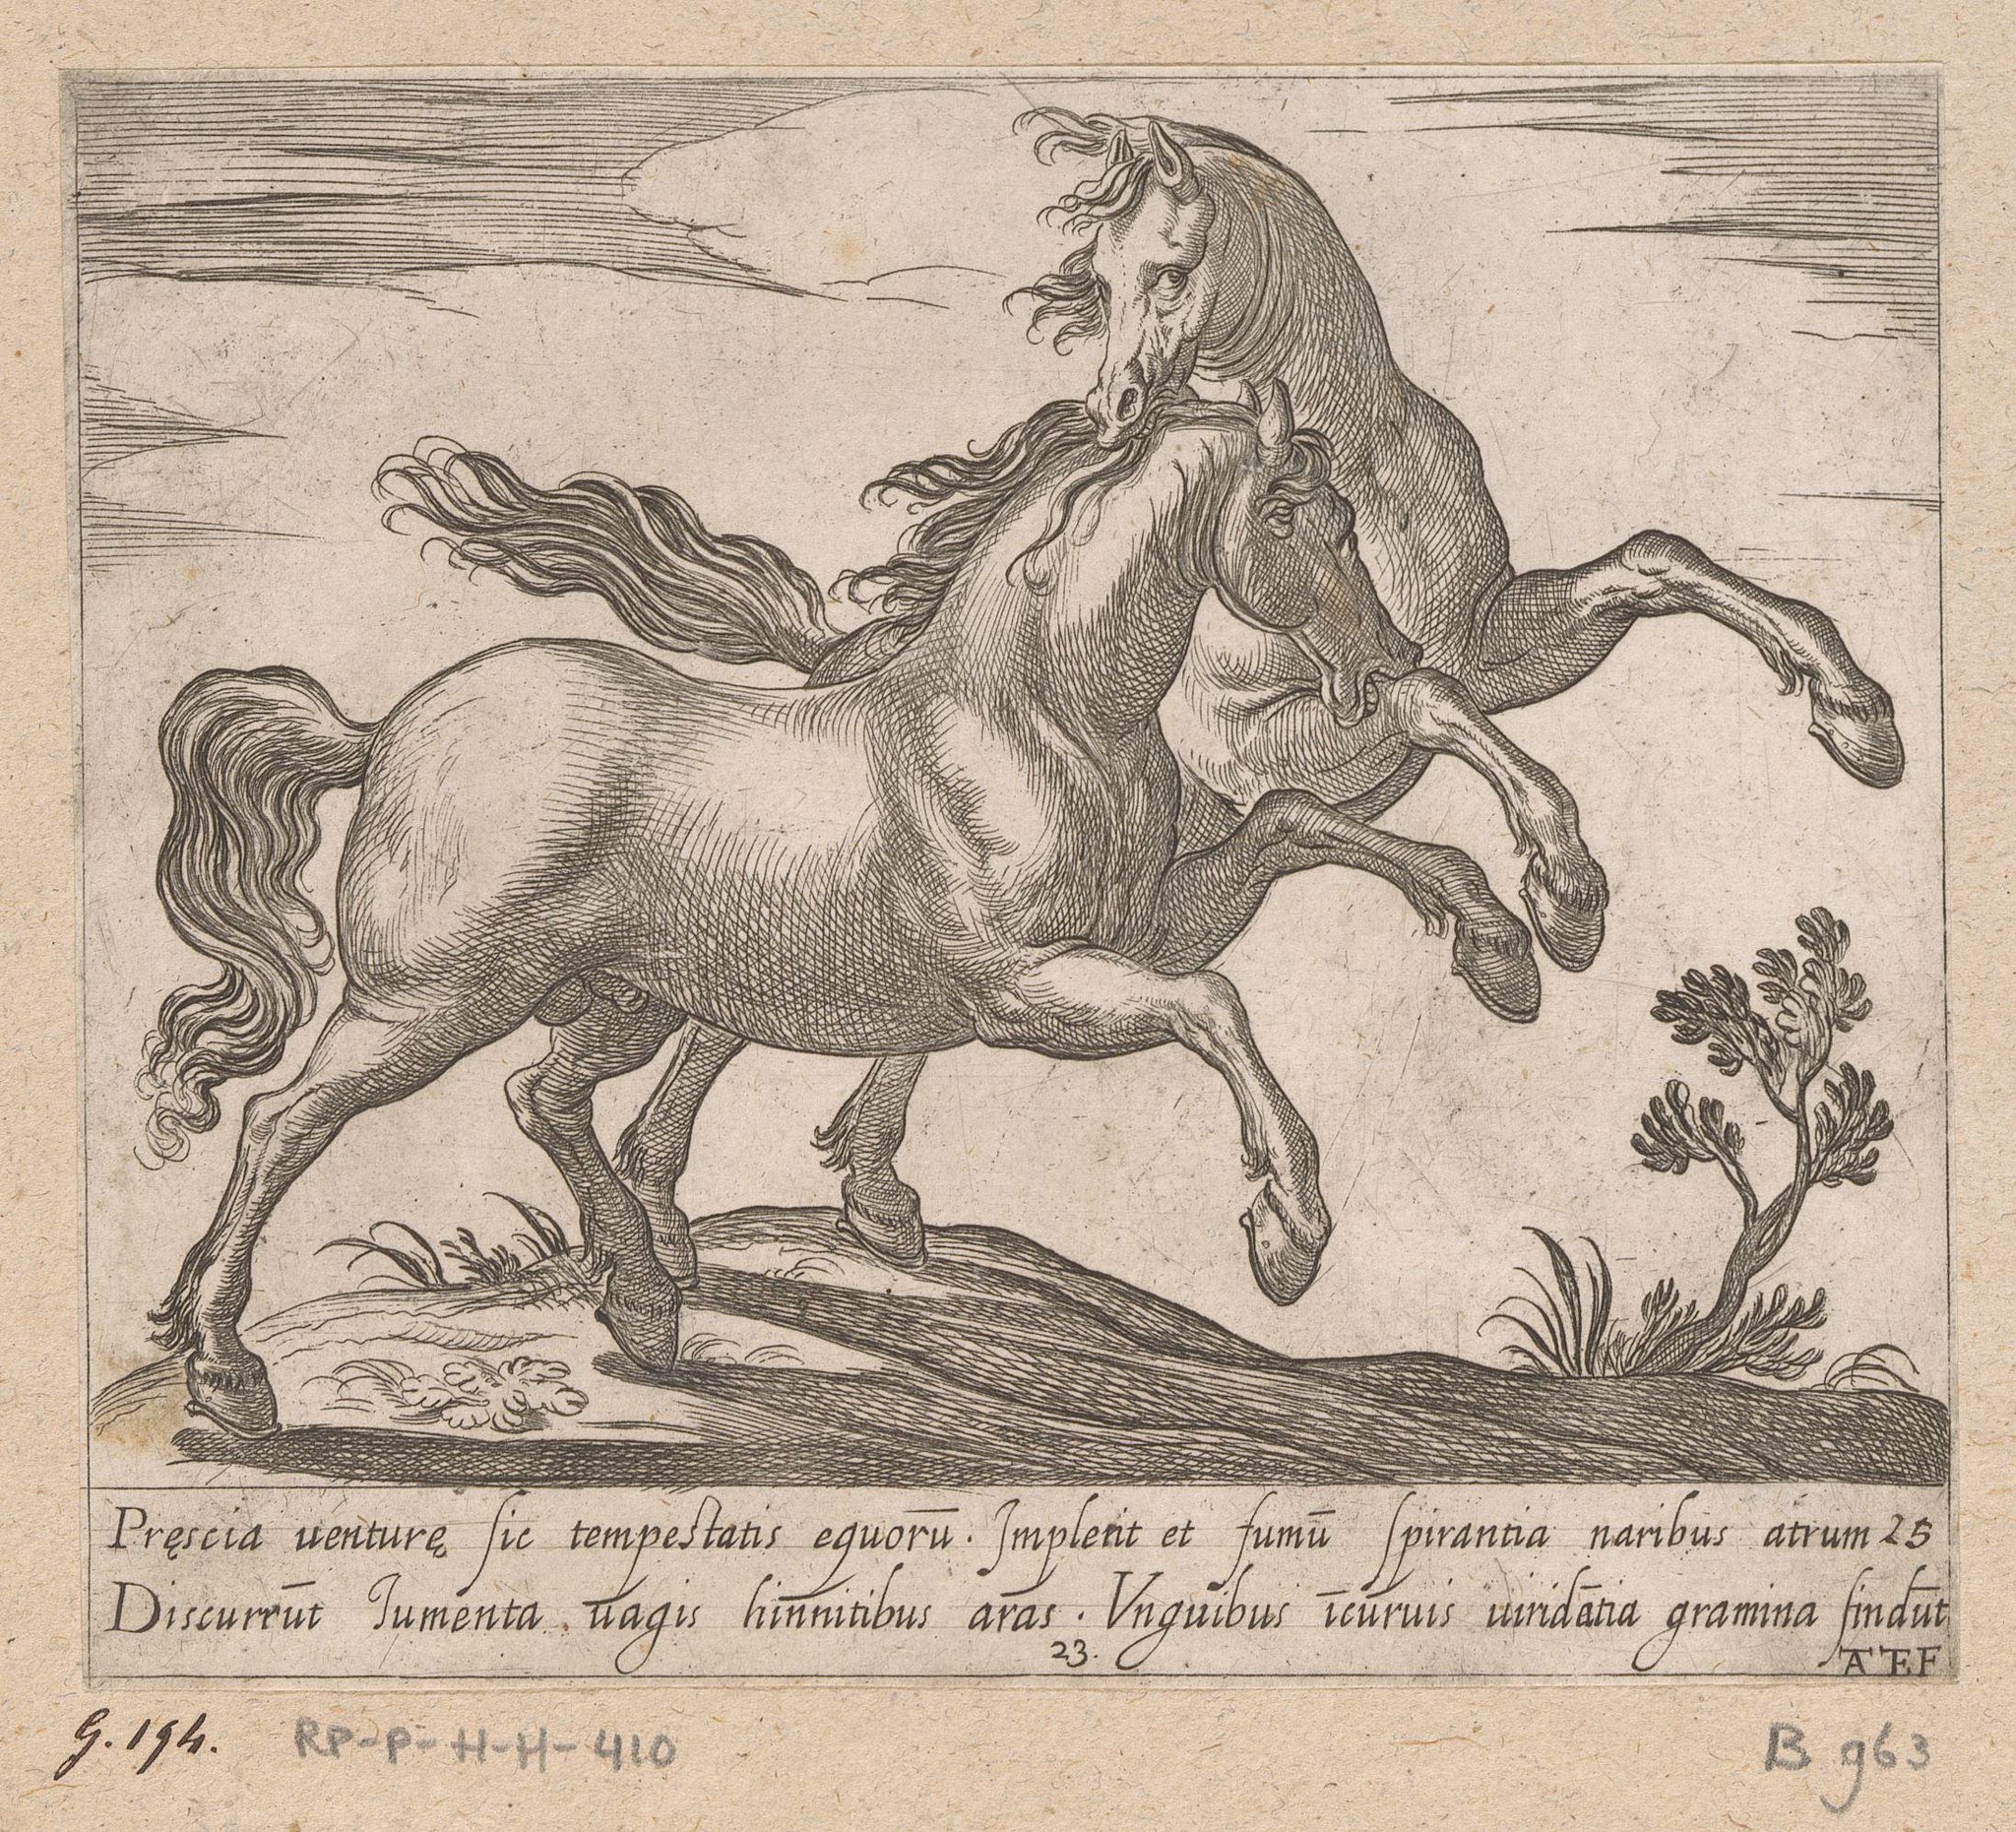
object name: print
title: Twee vechtende paarden naar rechts rennend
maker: antonio tempesta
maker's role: draughtsman, painter, print maker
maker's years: 1555-1630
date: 1590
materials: paper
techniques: etching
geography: italy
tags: horse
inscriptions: number: ‘25’, collector's mark: Lugt 11, collector's mark: ‘Hinloopen’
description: Deze prent maakt deel uit van een reeks van 28 prenten van paarden (+ titelprent en opdracht).